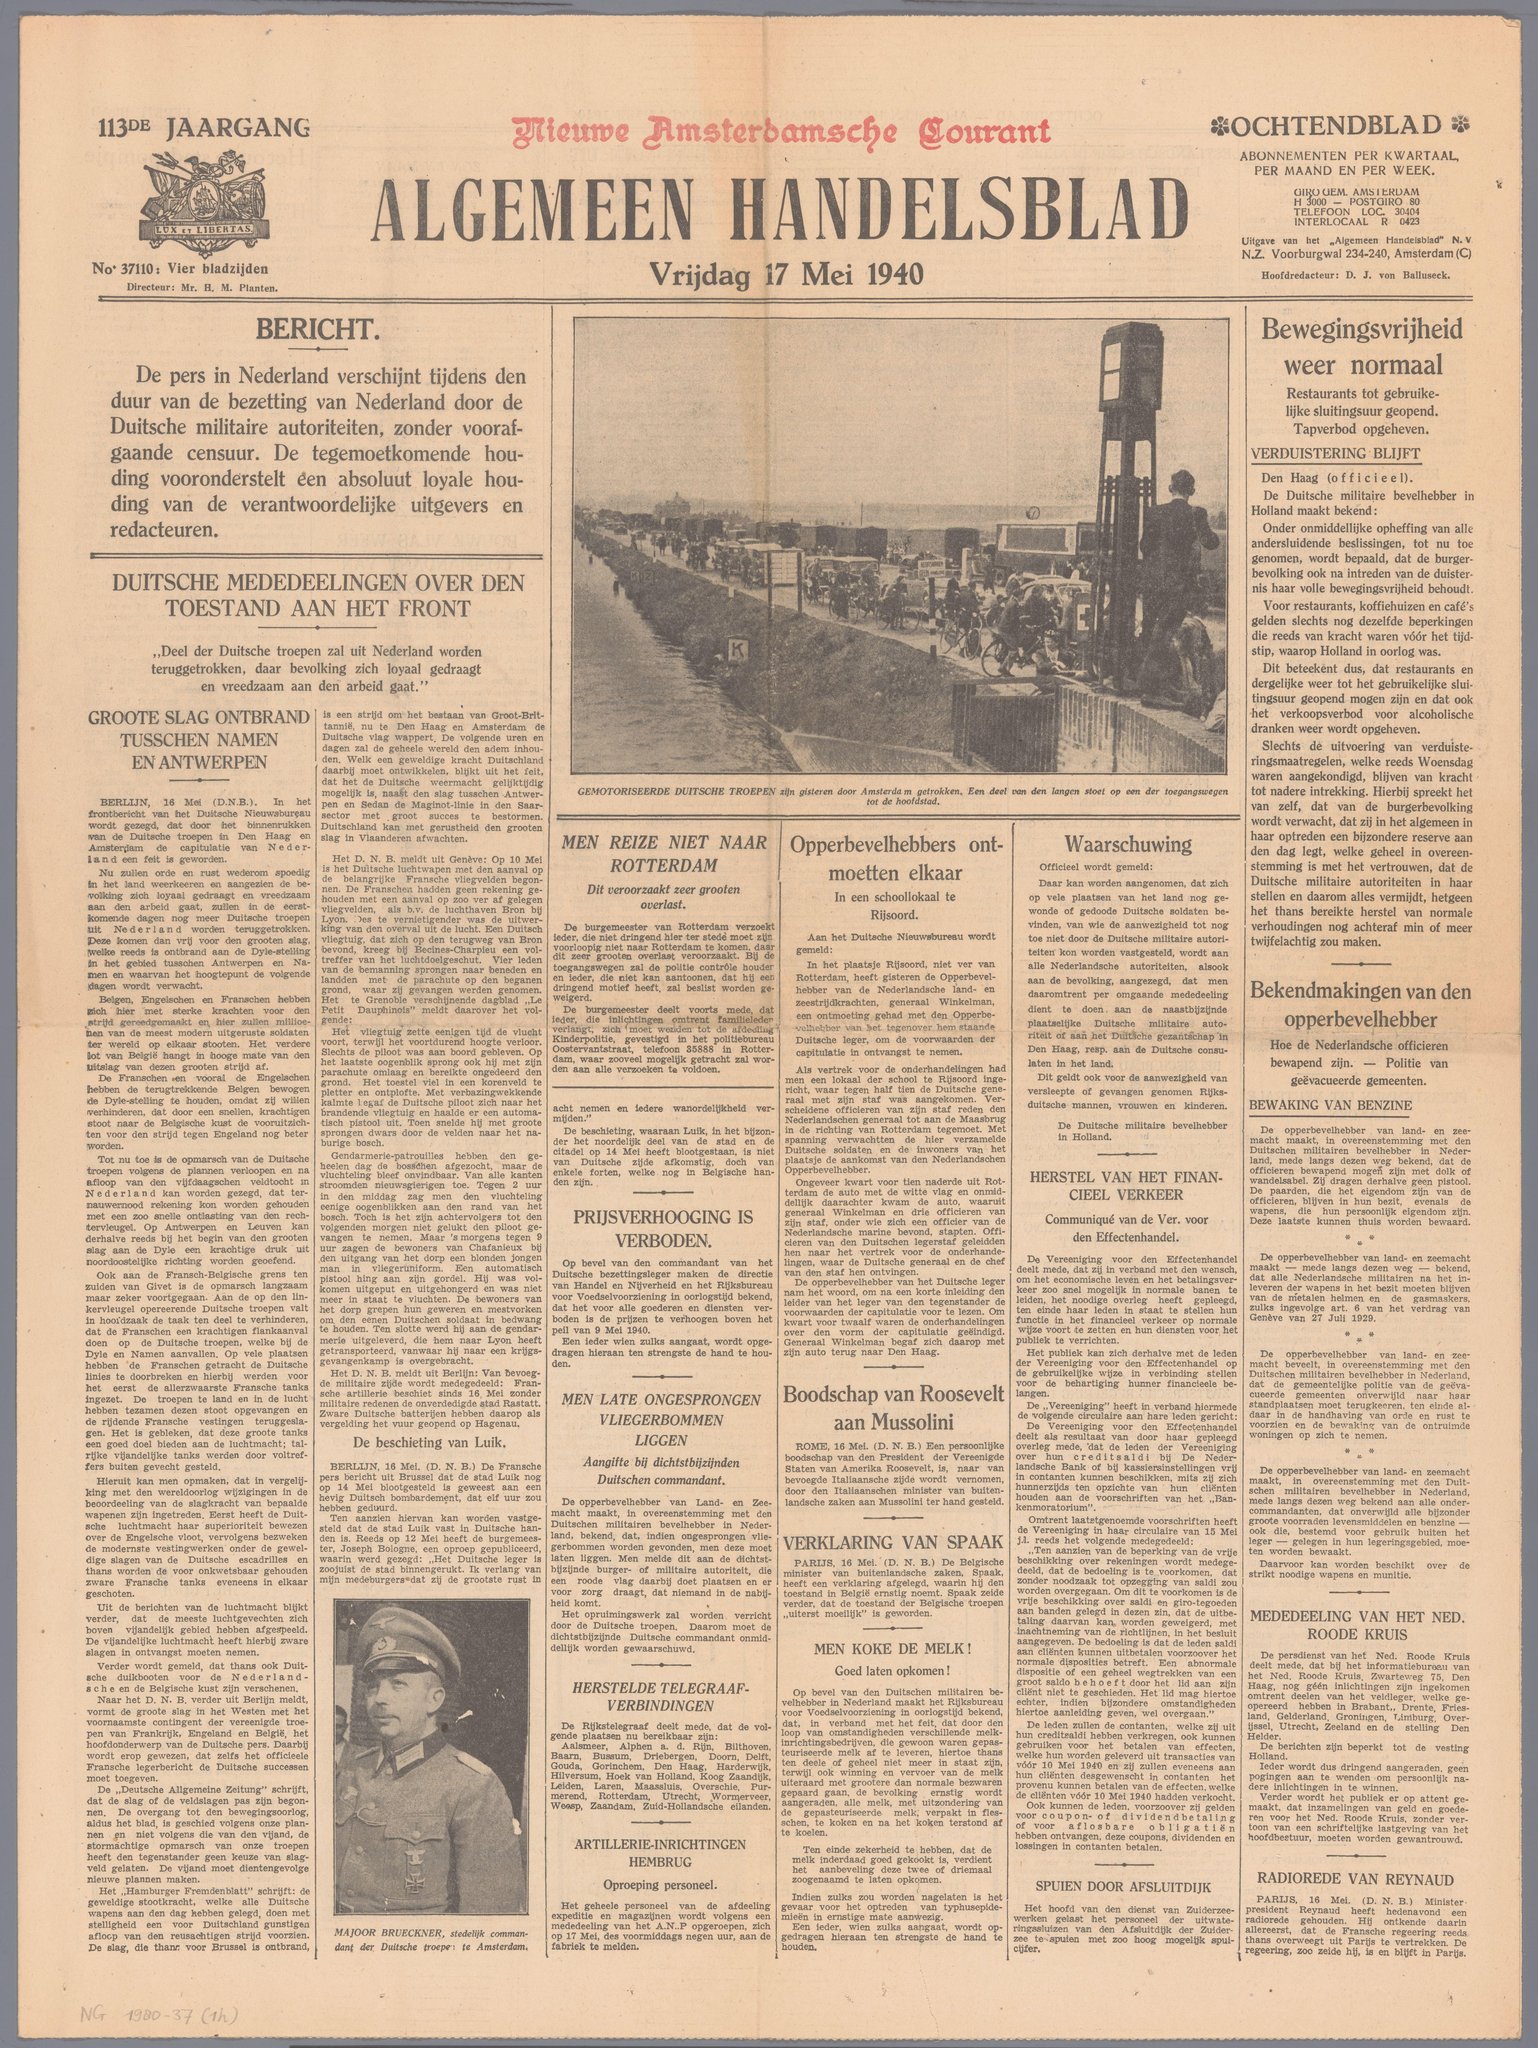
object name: newspaper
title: Algemeen Handelsblad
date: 1940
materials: paper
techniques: printing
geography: amsterdam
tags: netherlands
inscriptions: date